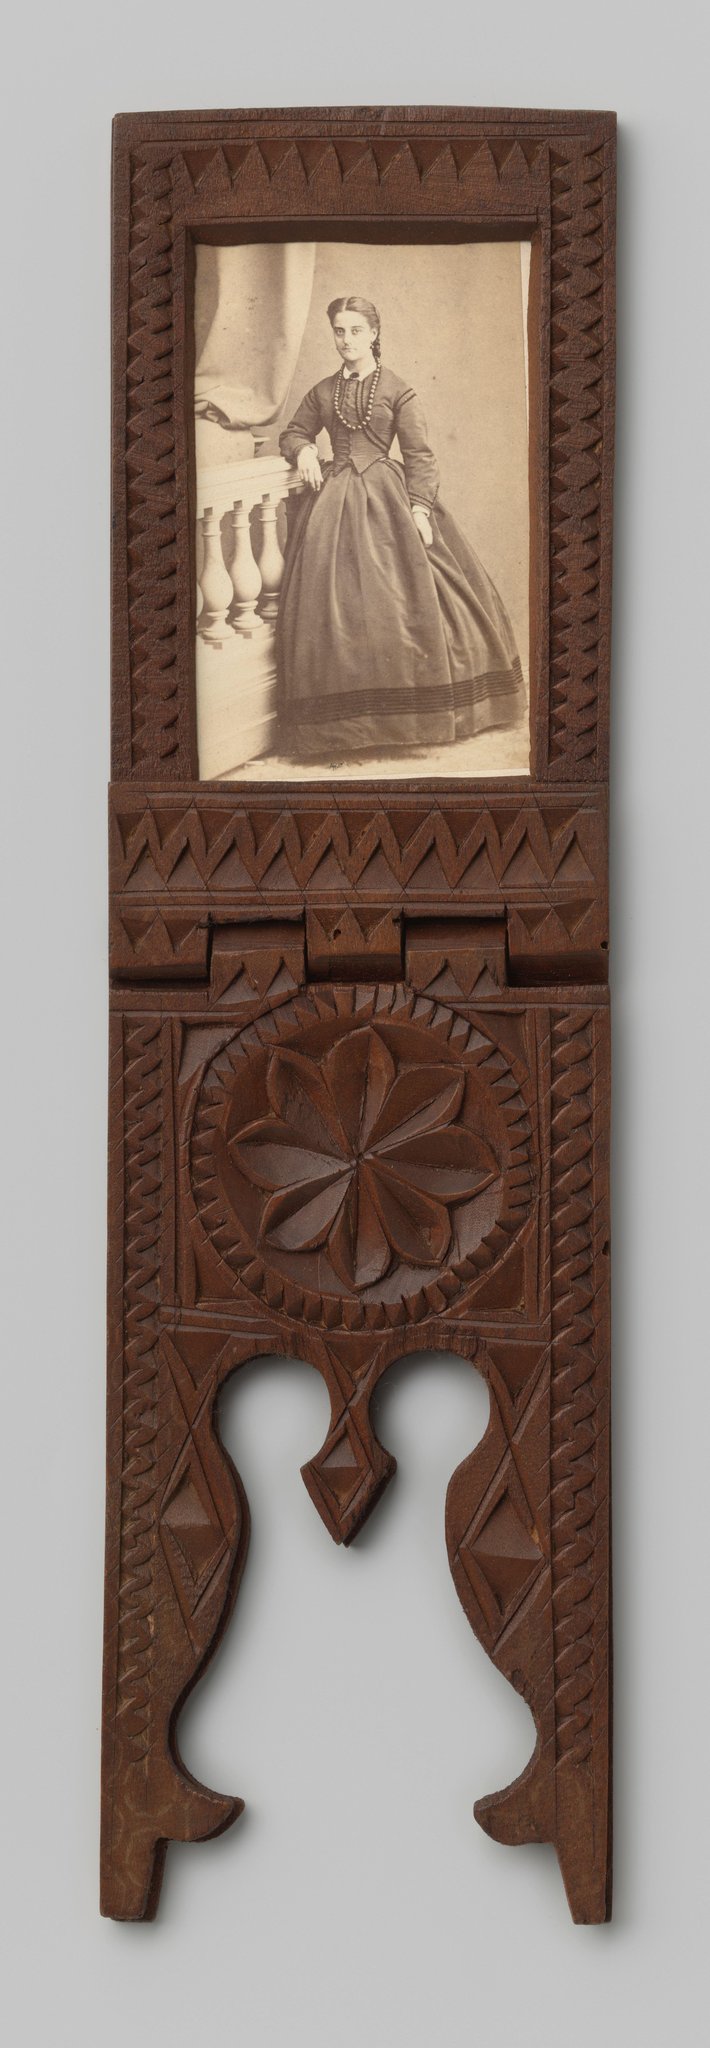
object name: photograph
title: Portret van een onbekende vrouw, leunend op een balustrade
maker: auguste leslay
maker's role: fotograaf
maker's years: 1832-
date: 1865-1875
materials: cardboard, paper, wood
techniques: albumen print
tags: anonymous historical person portrayed alone - bb - woman, balustrade